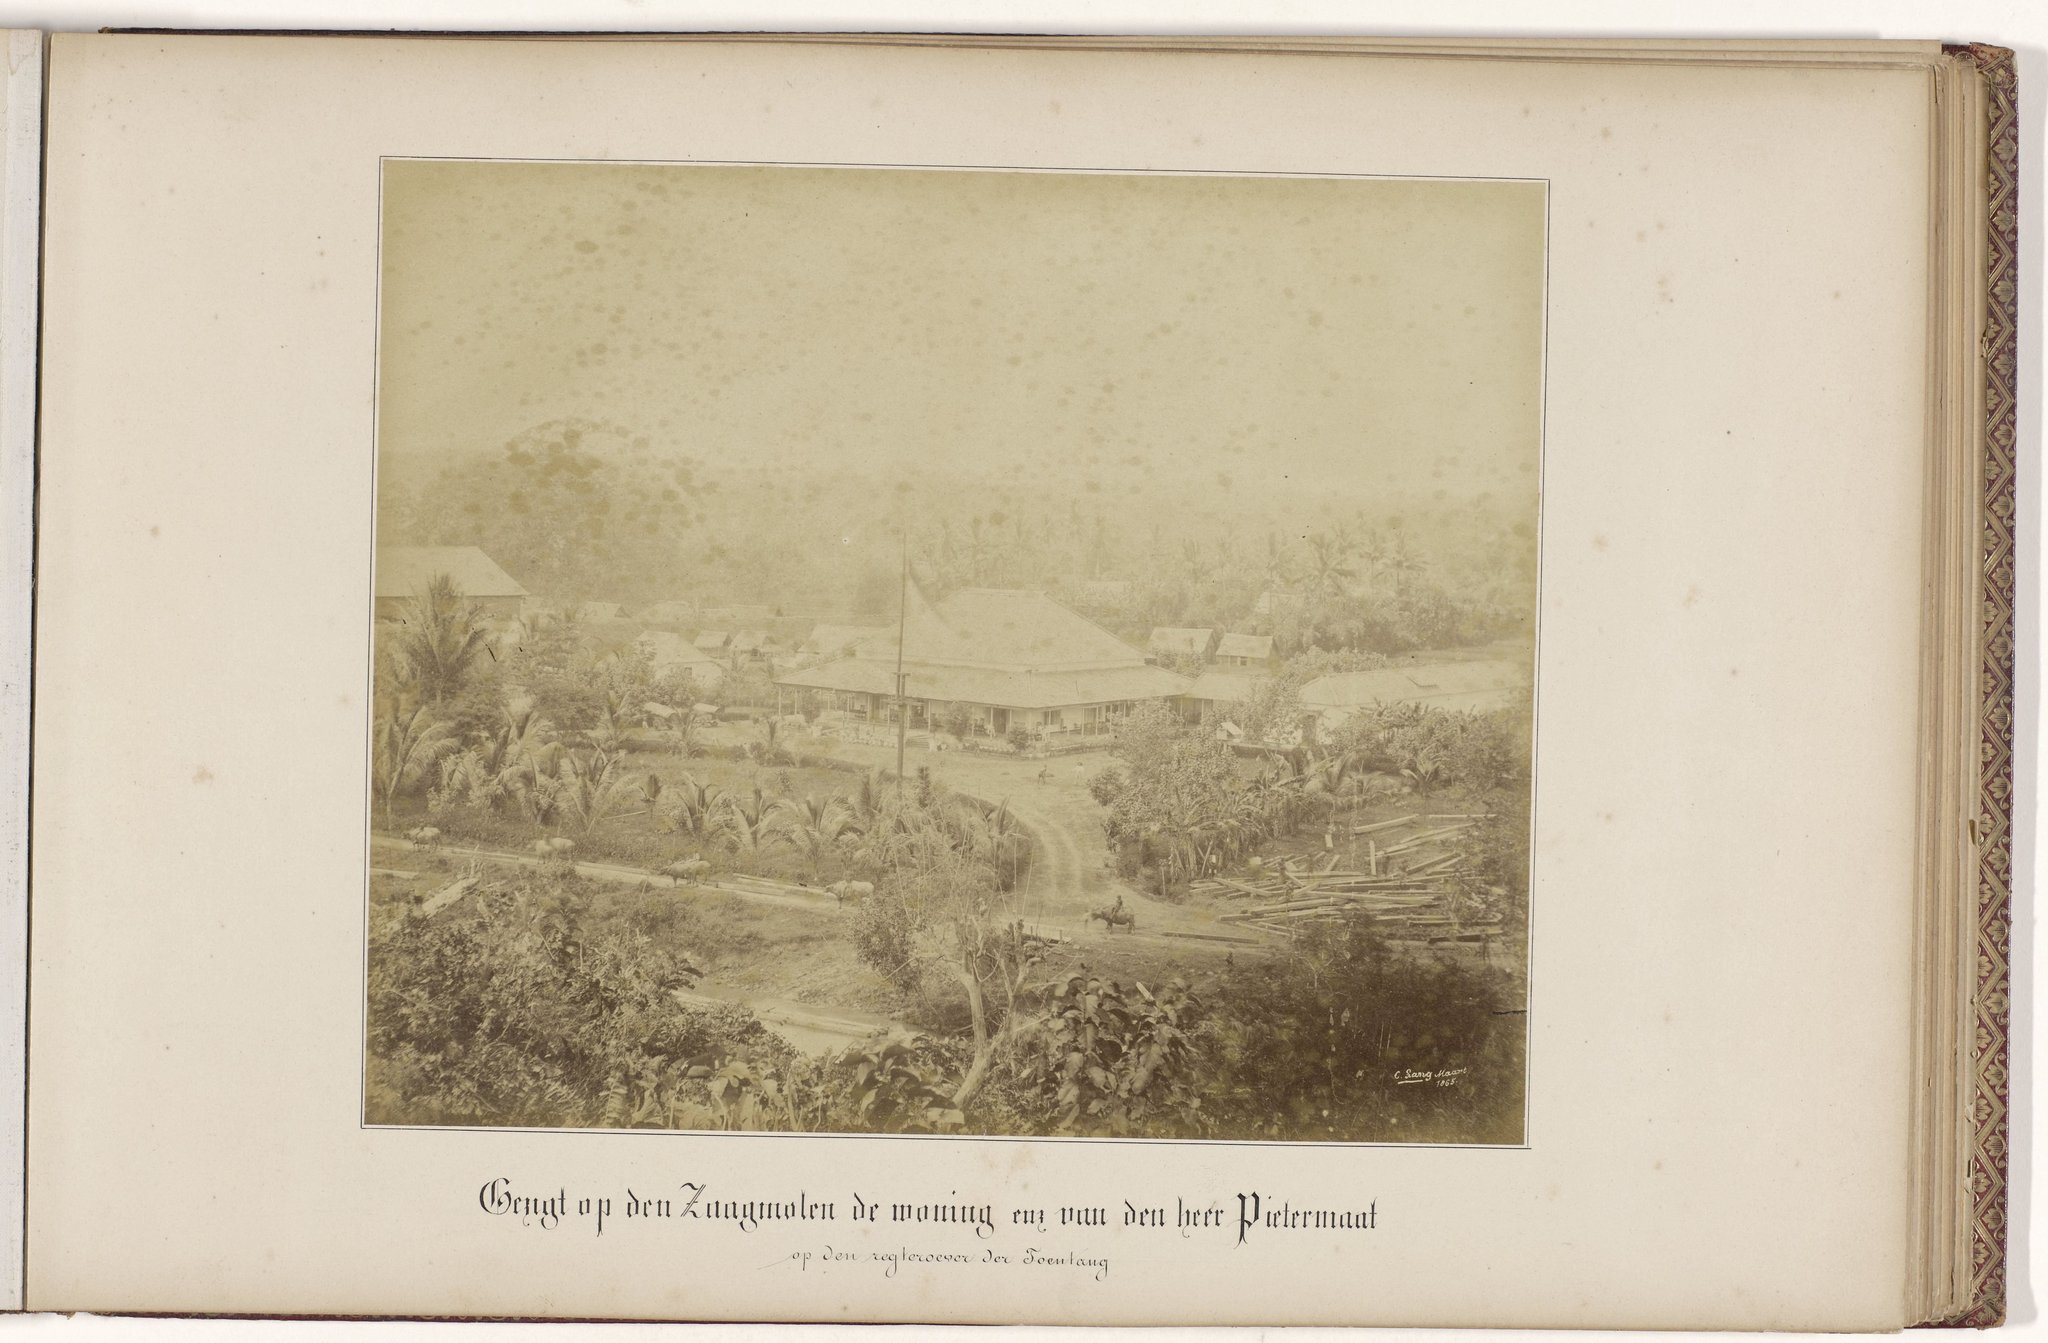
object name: photograph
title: Gezigt op den Zaagmolen de woning enz van den heer Pietermaat / op den regteroever der Toentang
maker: carl emanuel friedrich lang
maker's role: draughtsman, print maker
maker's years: -1906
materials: cardboard, photographic support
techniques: albumen print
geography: java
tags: colonial system, railway-traffic, watermill, building-site, java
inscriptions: signature and date: ‘C. Lang. Maart 1865’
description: Gezicht op de woning en zaagmolen van de heer Pietermaat, gelegen aan de oever van de rivier de Kali Tuntang. Albumblad met opgeplakte foto, onderdeel van het fotoalbum over de aanleg van de spoorlijn Semarang - Kedoeng Djattie (Kedungjati) op Java in 1865.